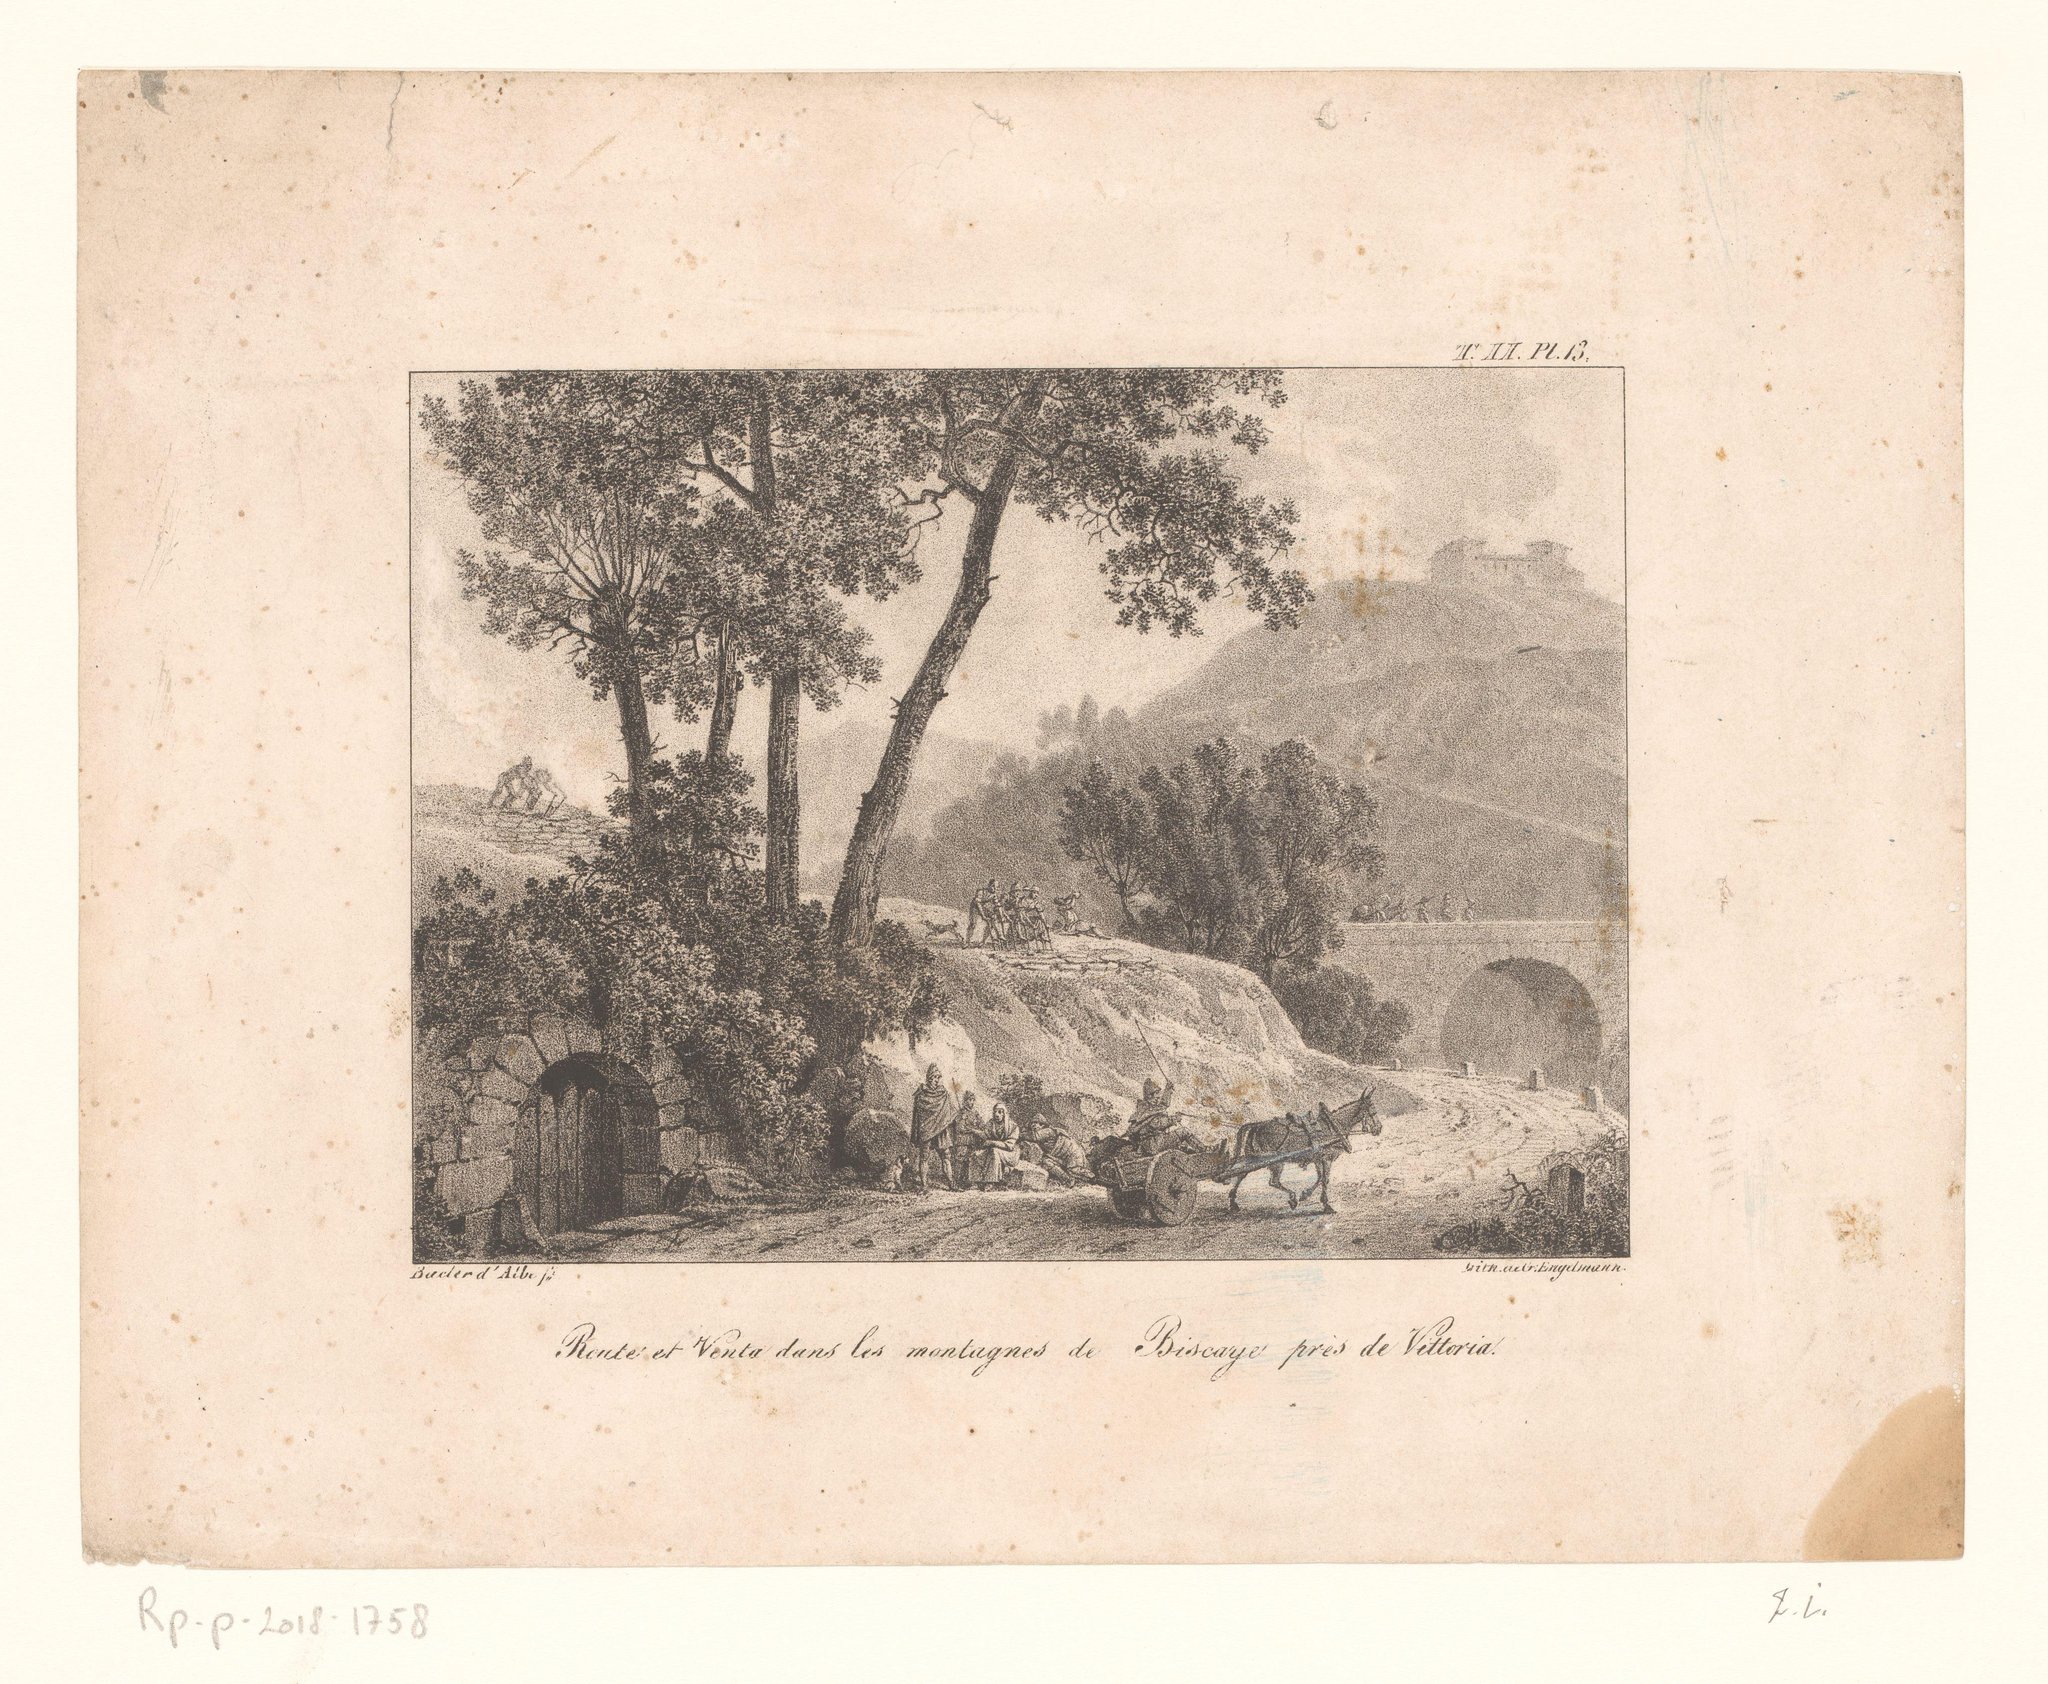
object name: print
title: Landschap in Biskaje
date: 1815-1824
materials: paper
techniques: lithograph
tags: mountains, vizcaya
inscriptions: collector's mark: Lugt 2228